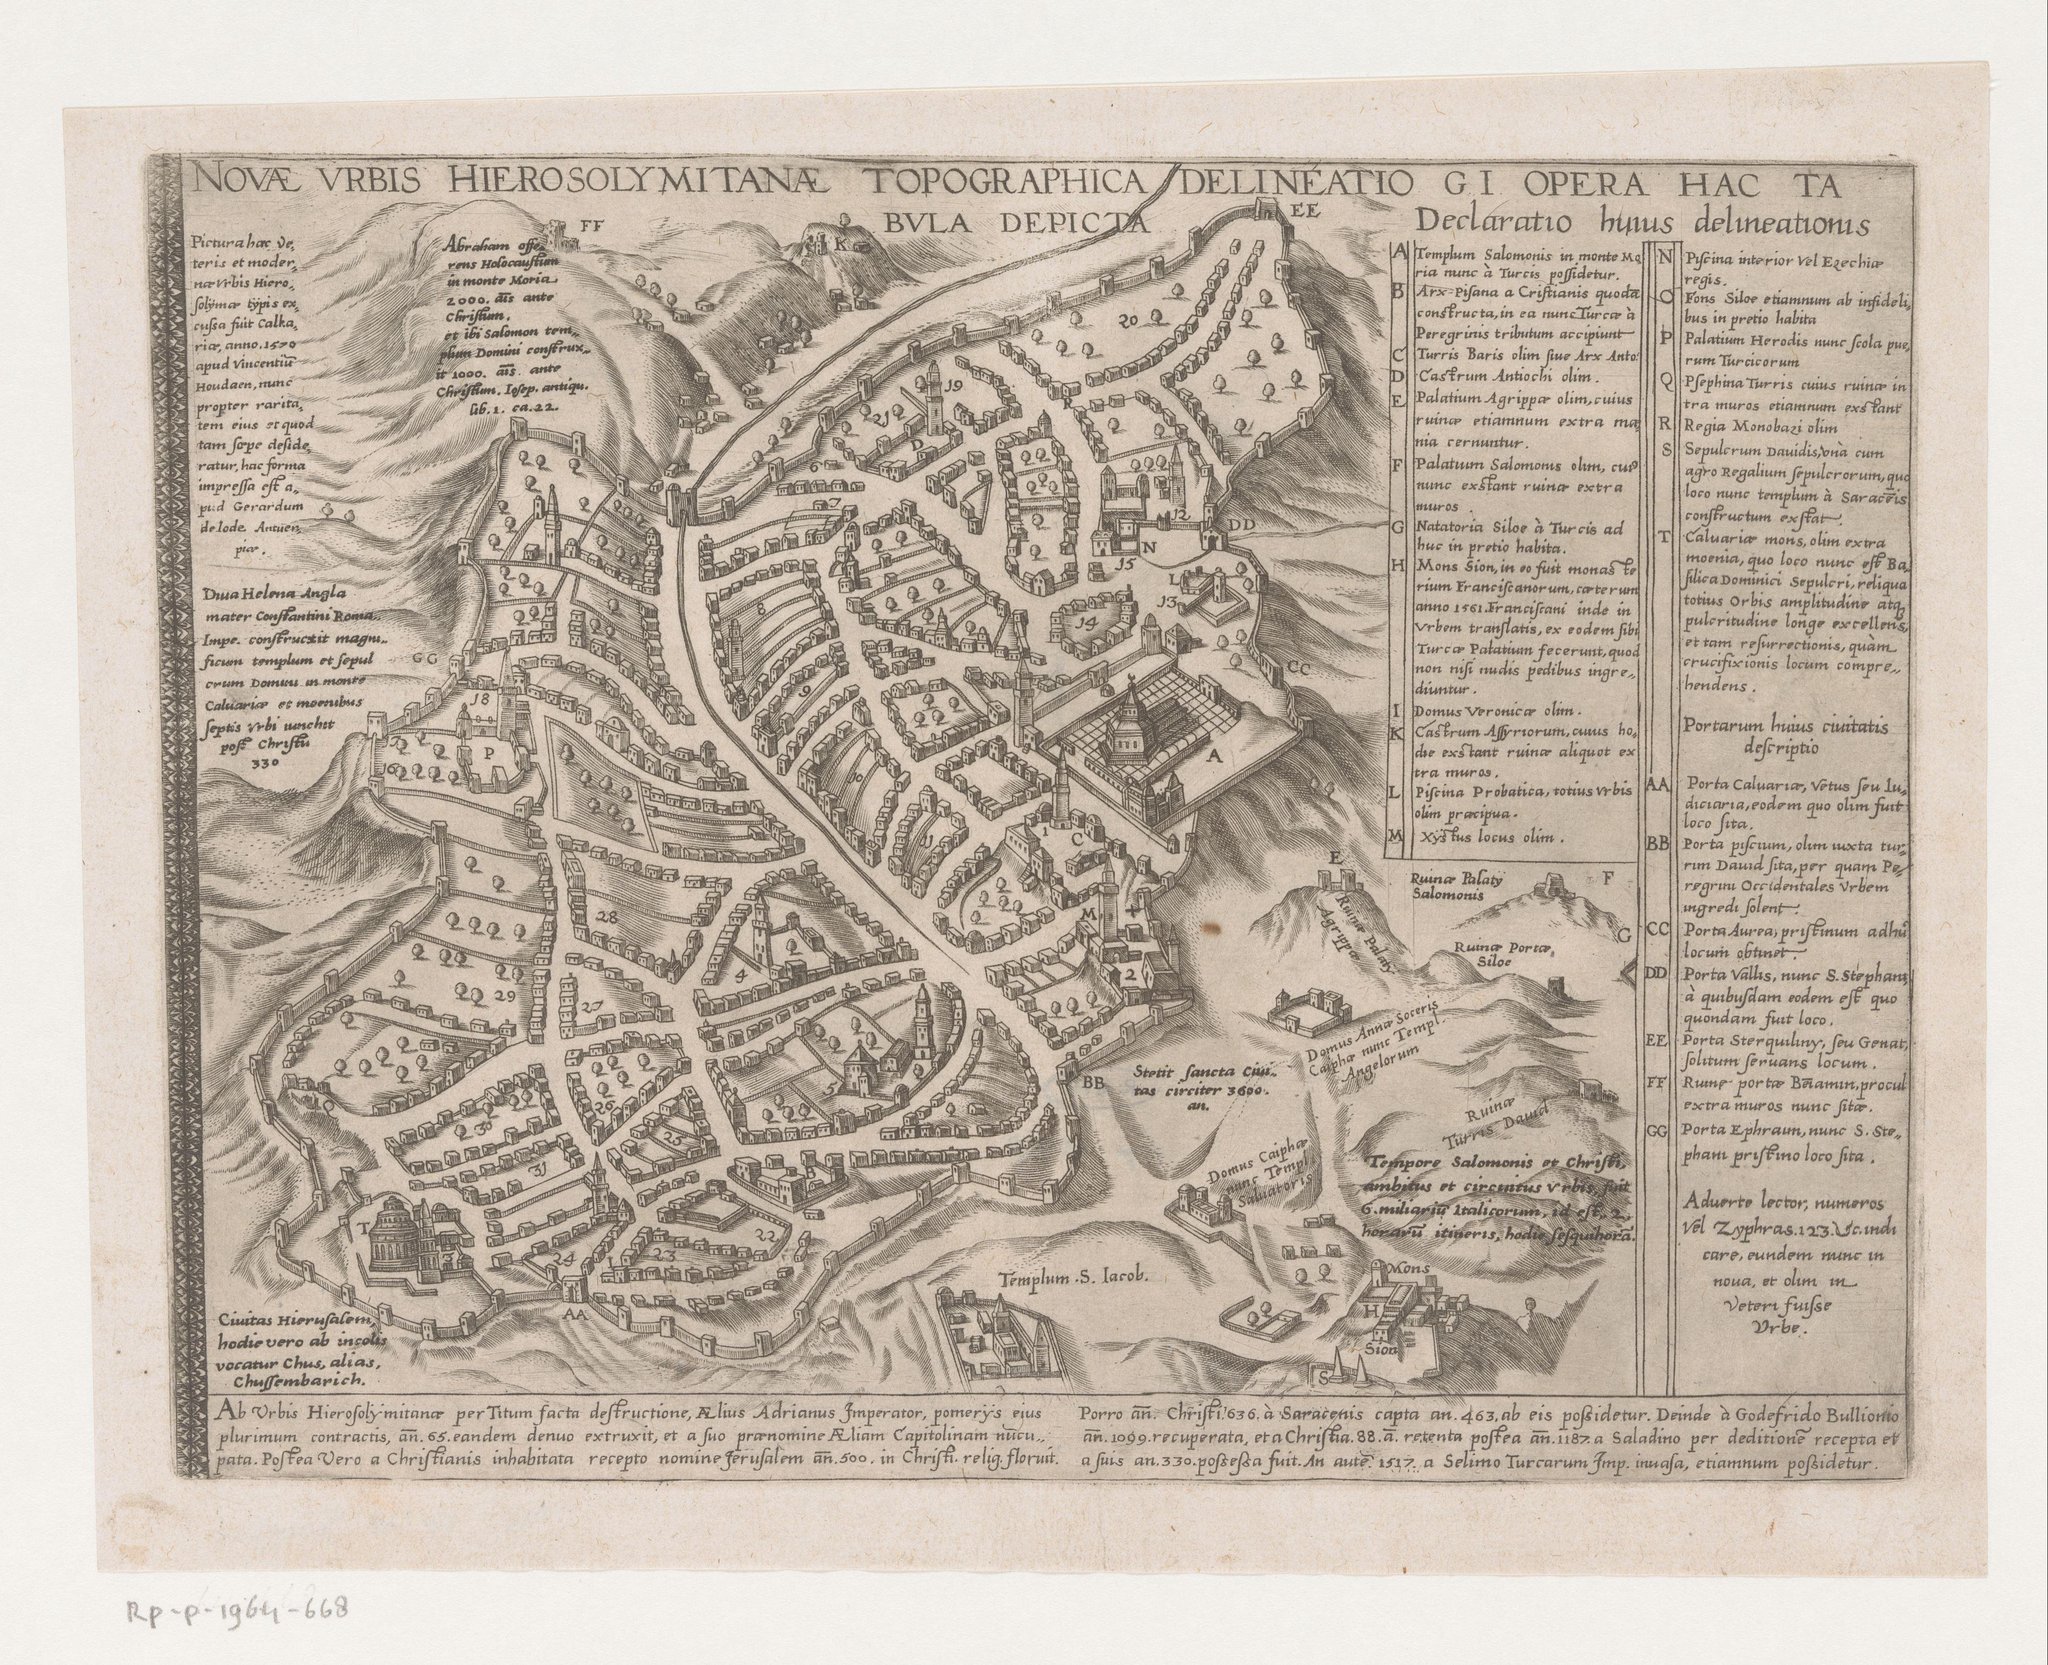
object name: print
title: Vogelvluchtaanzicht van Jeruzalem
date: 1518-1591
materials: paper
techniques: etching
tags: maps, atlases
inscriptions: collector's mark: Lugt 2228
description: Vogelvluchtaanzicht van Jeruzalem met tekst in Latijn en verklarende namenlijst.